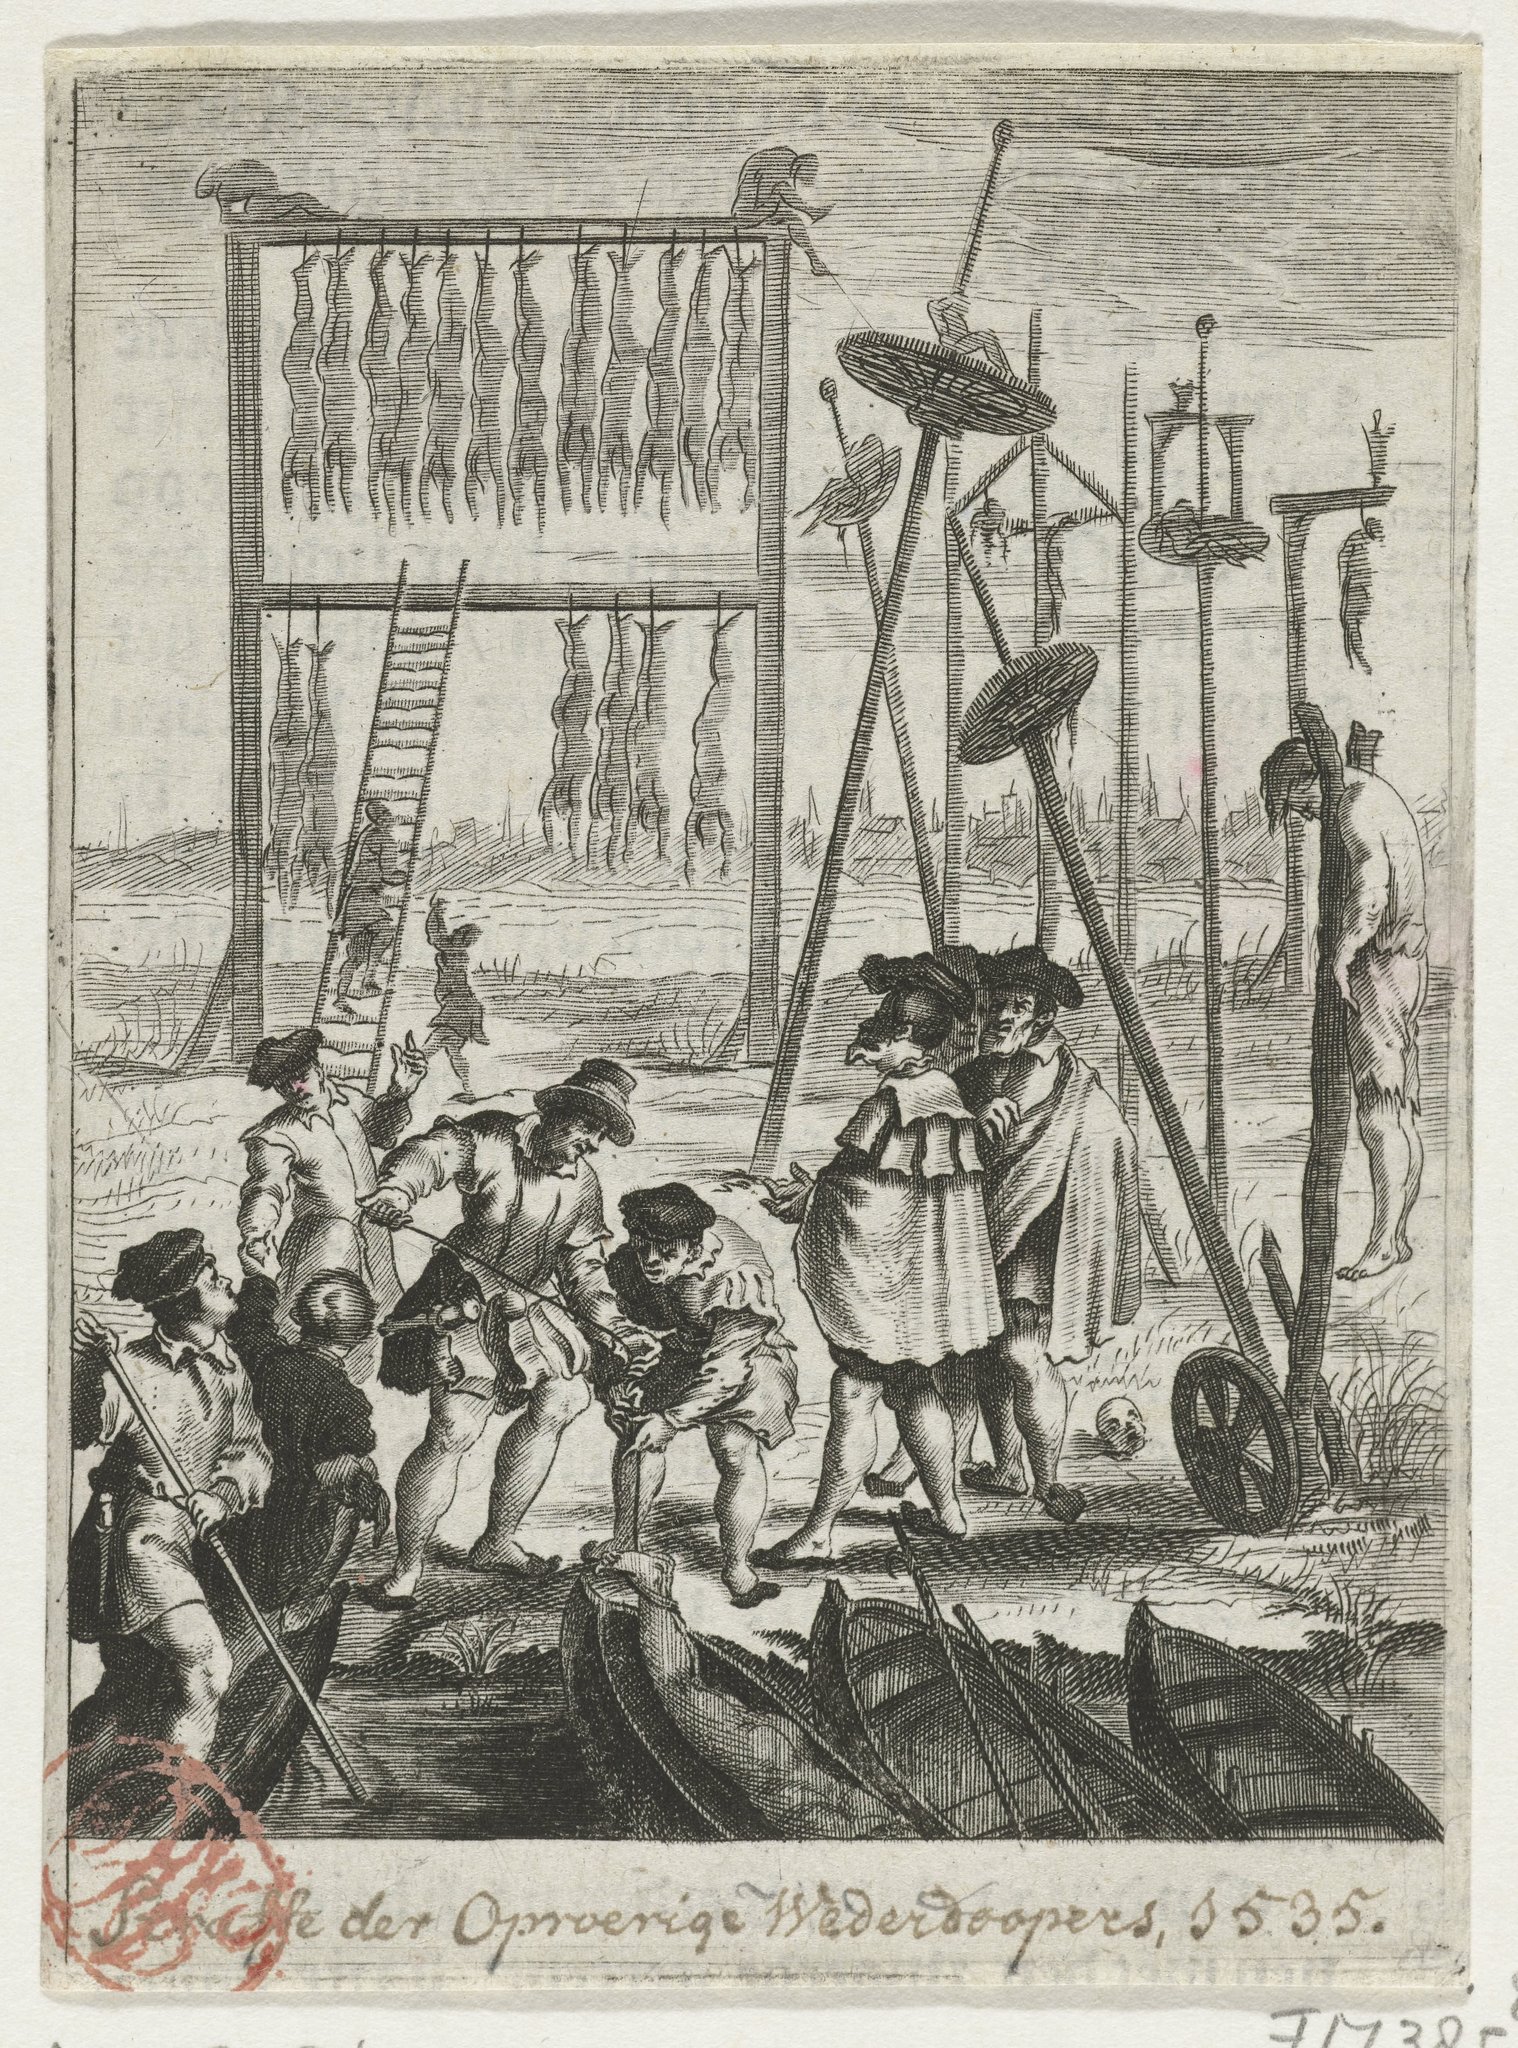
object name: print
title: De lijken van de wederdopers op het galgenveld, 1535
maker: Anonymous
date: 1657-1659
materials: paper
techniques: engraving, etching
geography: northern netherlands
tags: body of the executed displayed in public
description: Illustratie voor: L. Hortensius, Het boeck D. Lamberti Hortensii (...). Van den oproer der weder-dooperen, J.J. Schipper, Amsterdam 1659. De prenten in deze uitgave zijn gekopieerd naar de anonieme gravures in de eerste uitgave van 1614. Naar het verloren gegane schilderij van Barend Dircksz. in het oude stadhuis te Amsterdam.